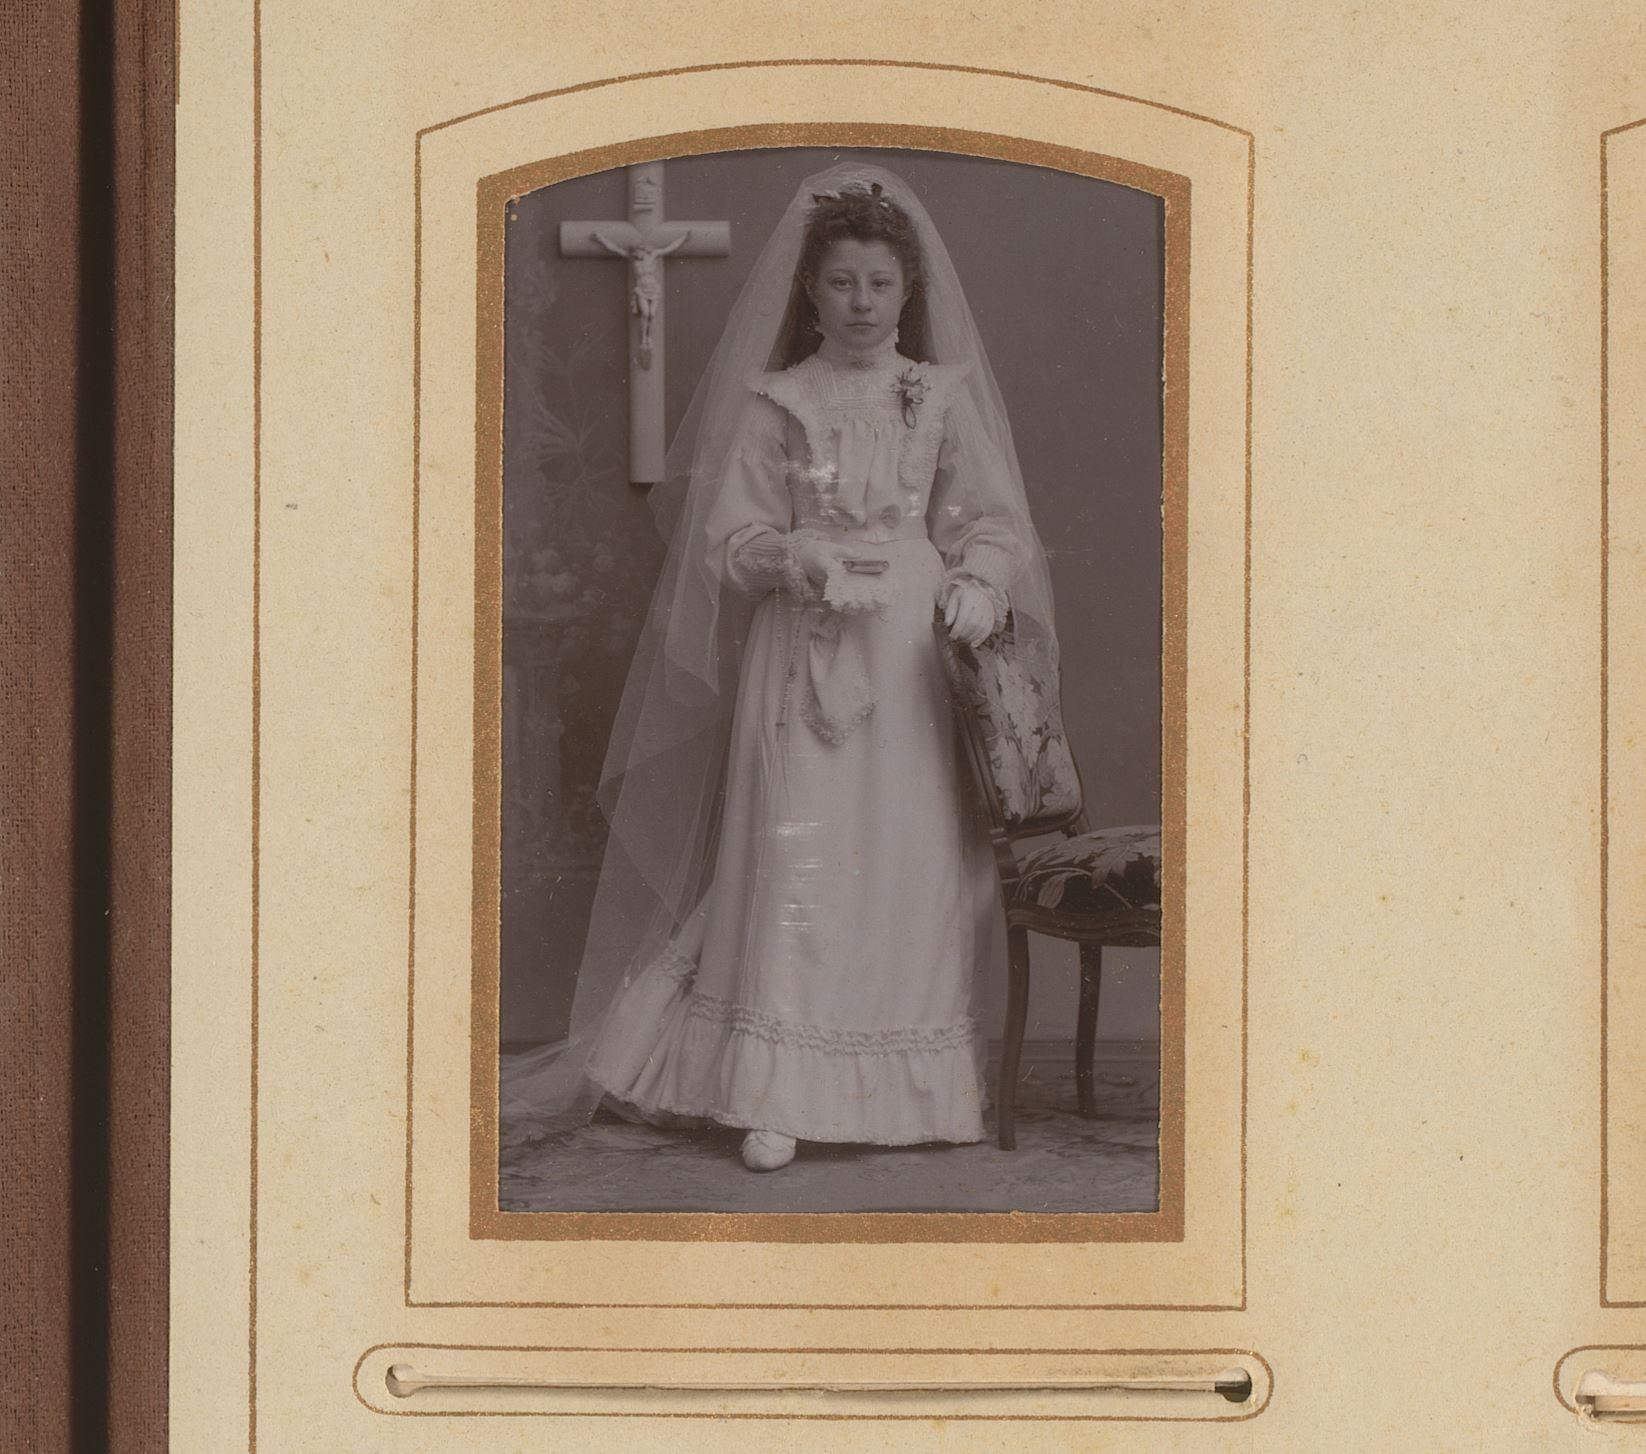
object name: photograph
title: Portret van een meisje in een communiejurk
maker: berend zweers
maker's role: fotograaf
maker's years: 1872-1946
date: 1923-1934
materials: cardboard, photographic support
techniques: collodion silver print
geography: haarlem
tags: communion dress, girl (child between toddler and youth)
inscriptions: inscription: ‘Berend Zweers/ Groote Houtstraat 174/ Haarlem’